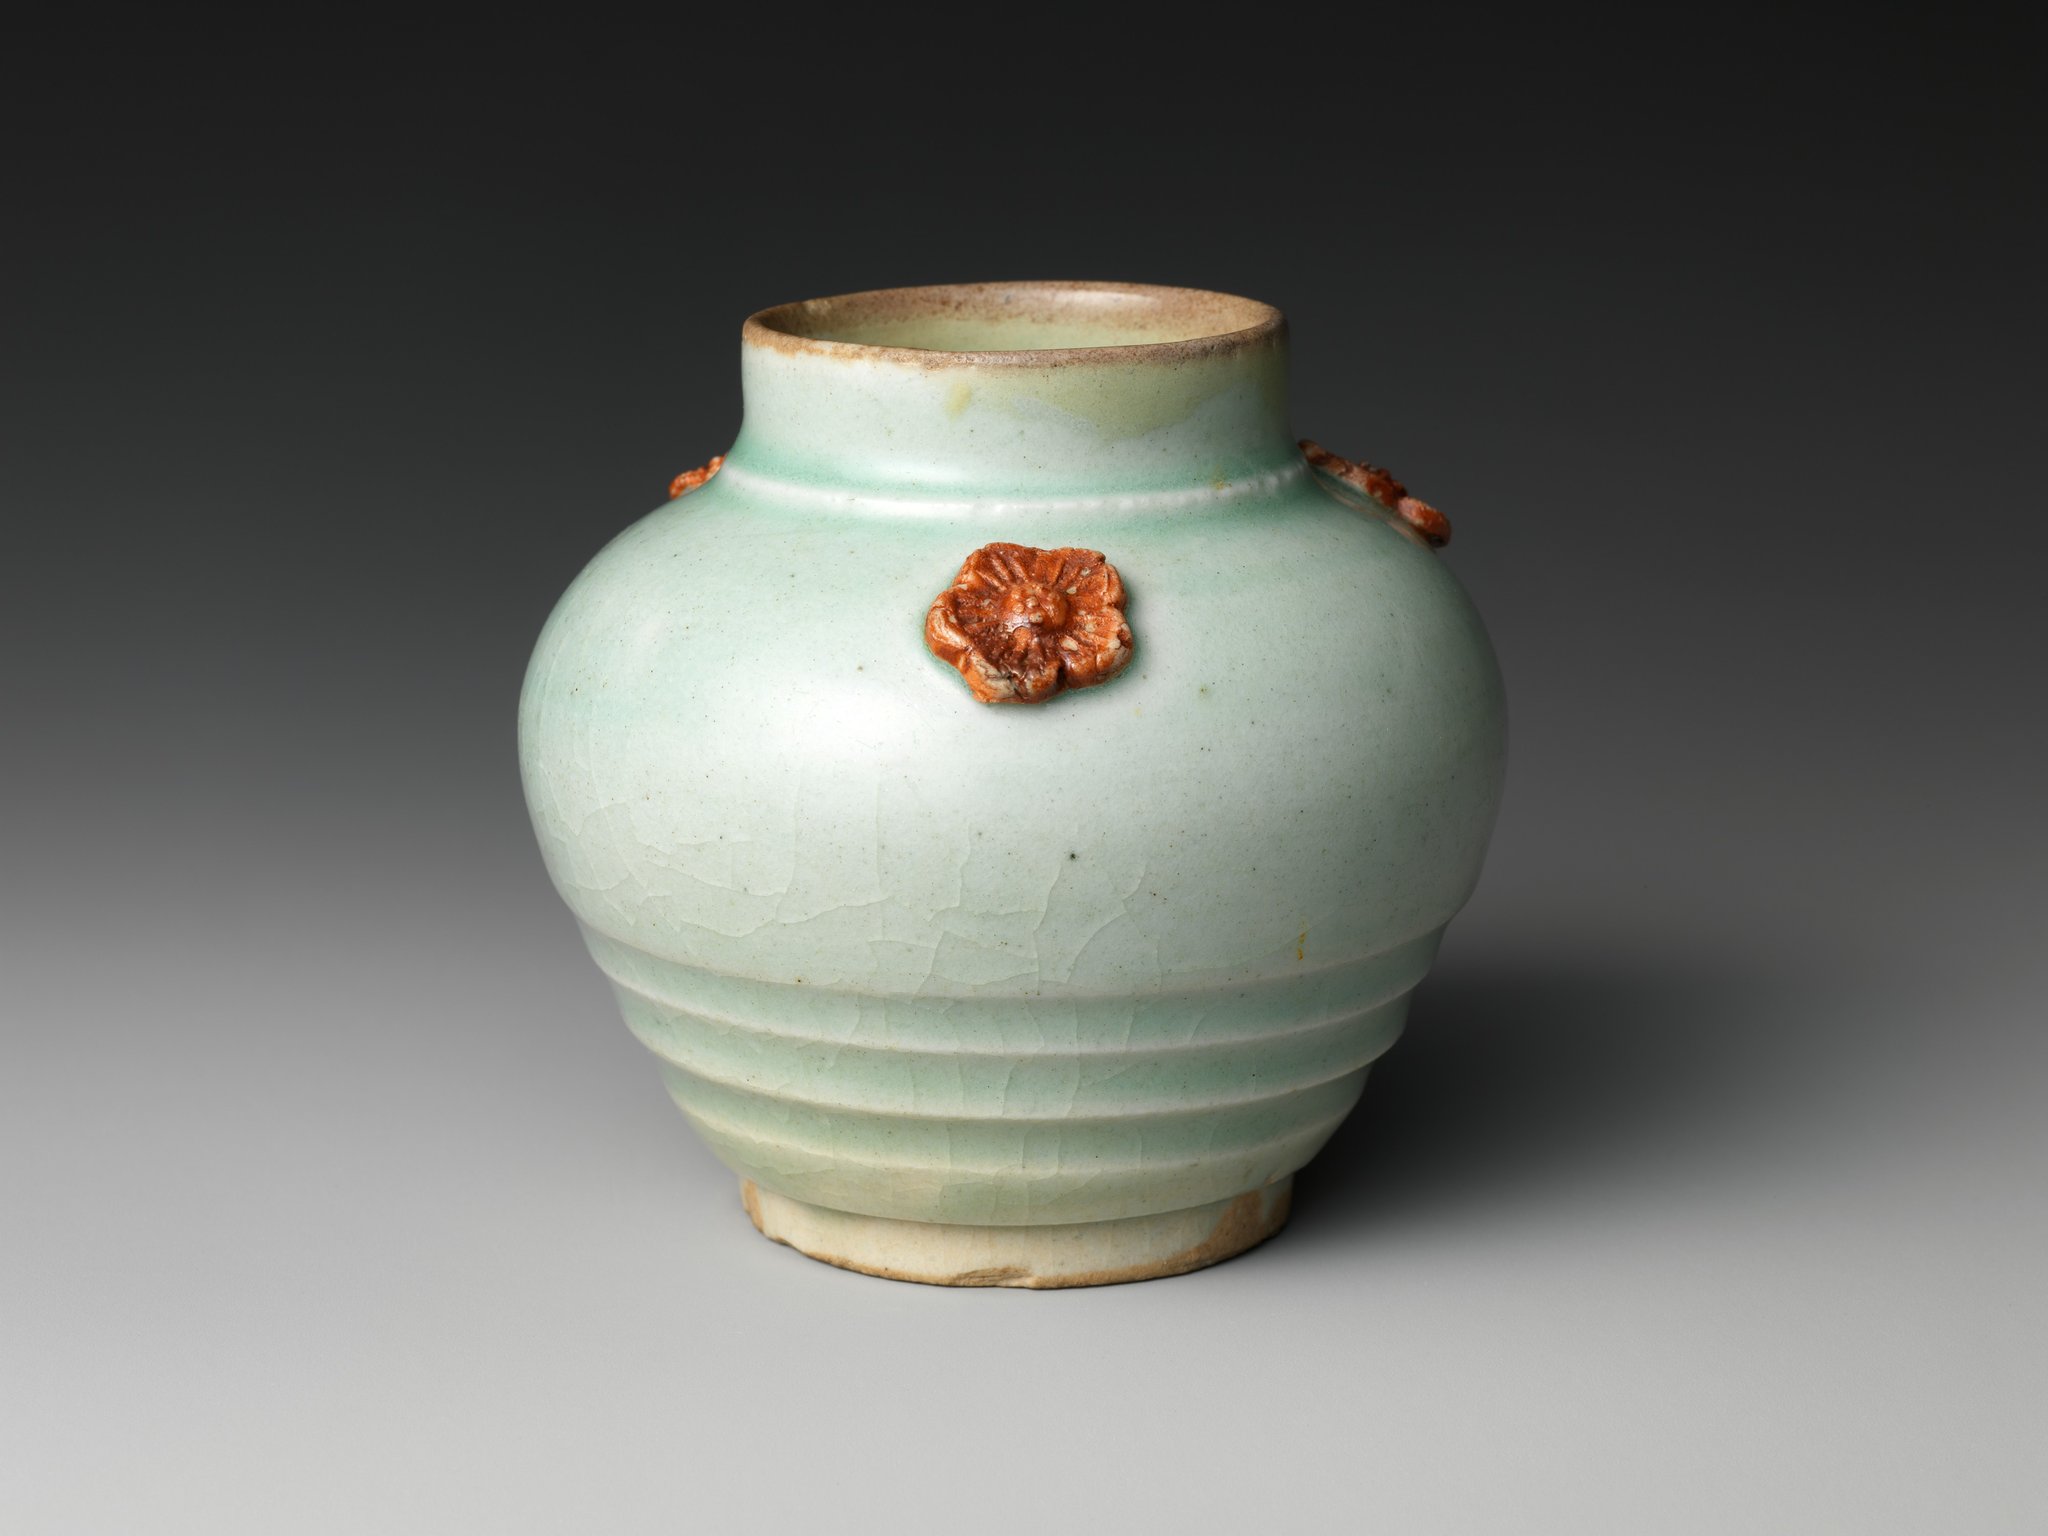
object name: jar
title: Small Jar with Floral Appliqué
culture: japanese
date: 1615-1868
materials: ceramic glaze, glaze, porcelain